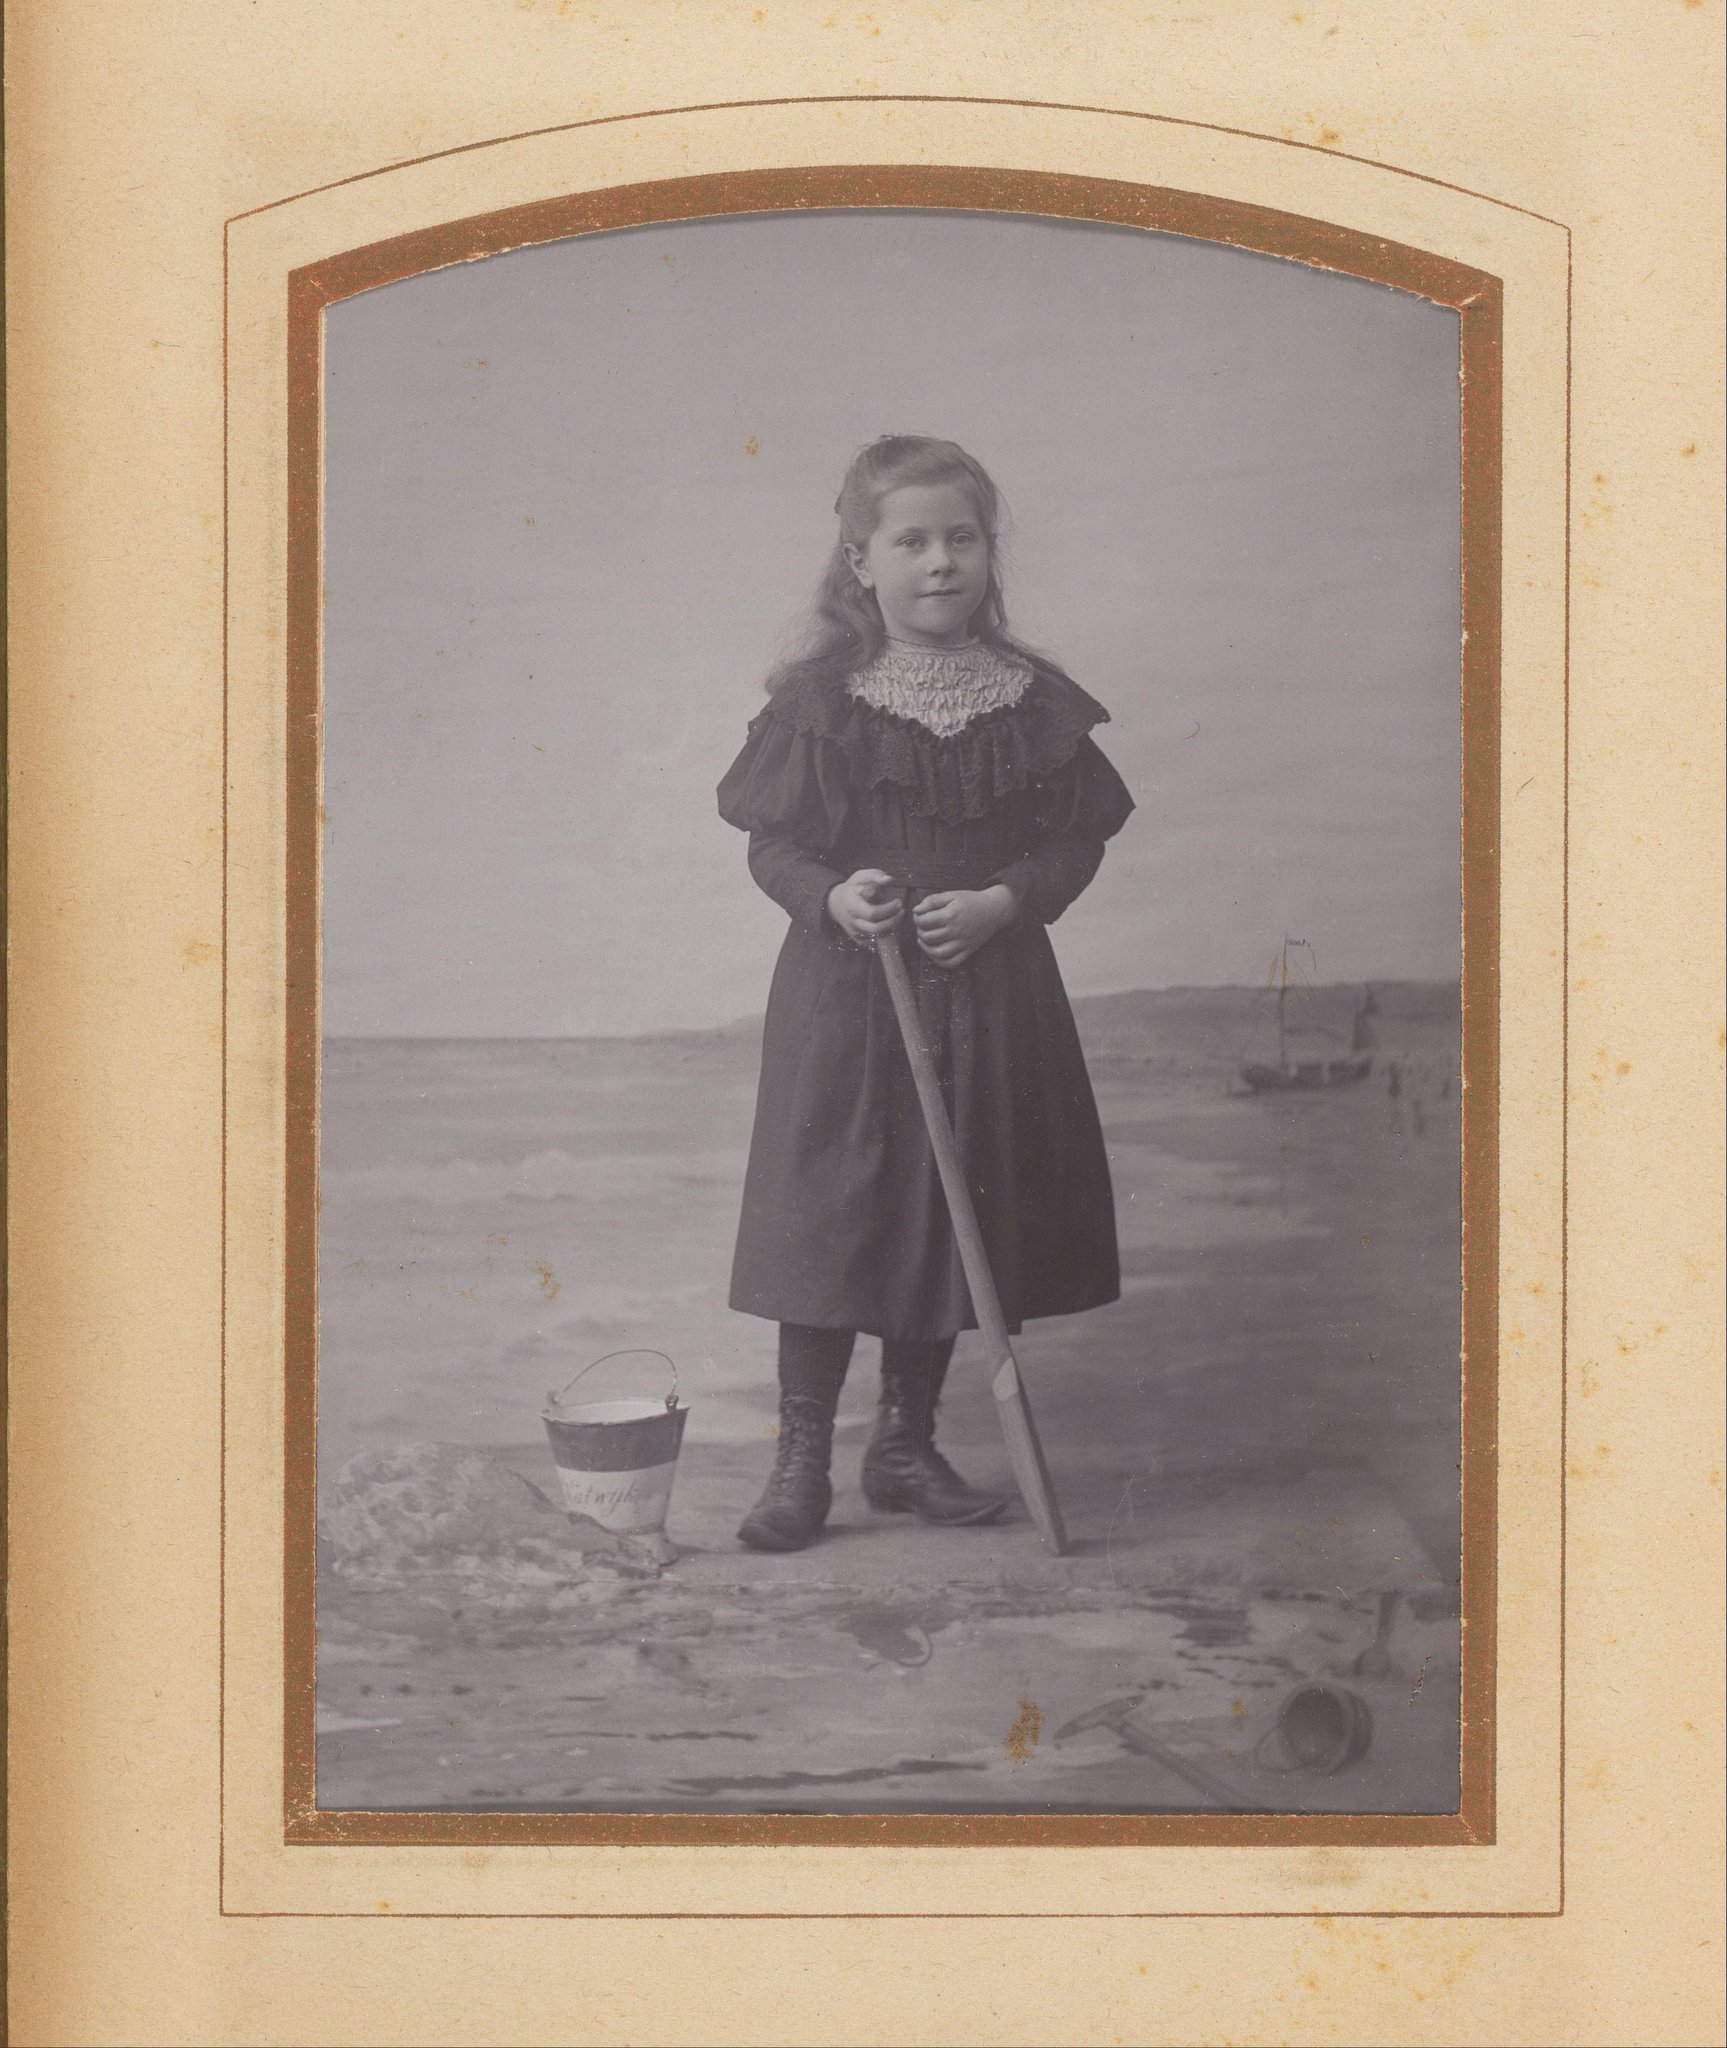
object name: photograph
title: Portret van een meisje met emmer en schep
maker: hendrik jonker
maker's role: fotograaf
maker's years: 1846-1932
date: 1899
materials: cardboard, photographic support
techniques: collodion silver print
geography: leiden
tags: historical persons - bb - woman, girl (child between toddler and youth)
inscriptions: inscription: ‘H. Jonker/ Leiden/ Apothedersdijk No.7’, inscription: ‘H. Jonker/ Photographisch Atelier/ Leiden/ Apothekersdijk No.7’, date: ‘2/4 99’